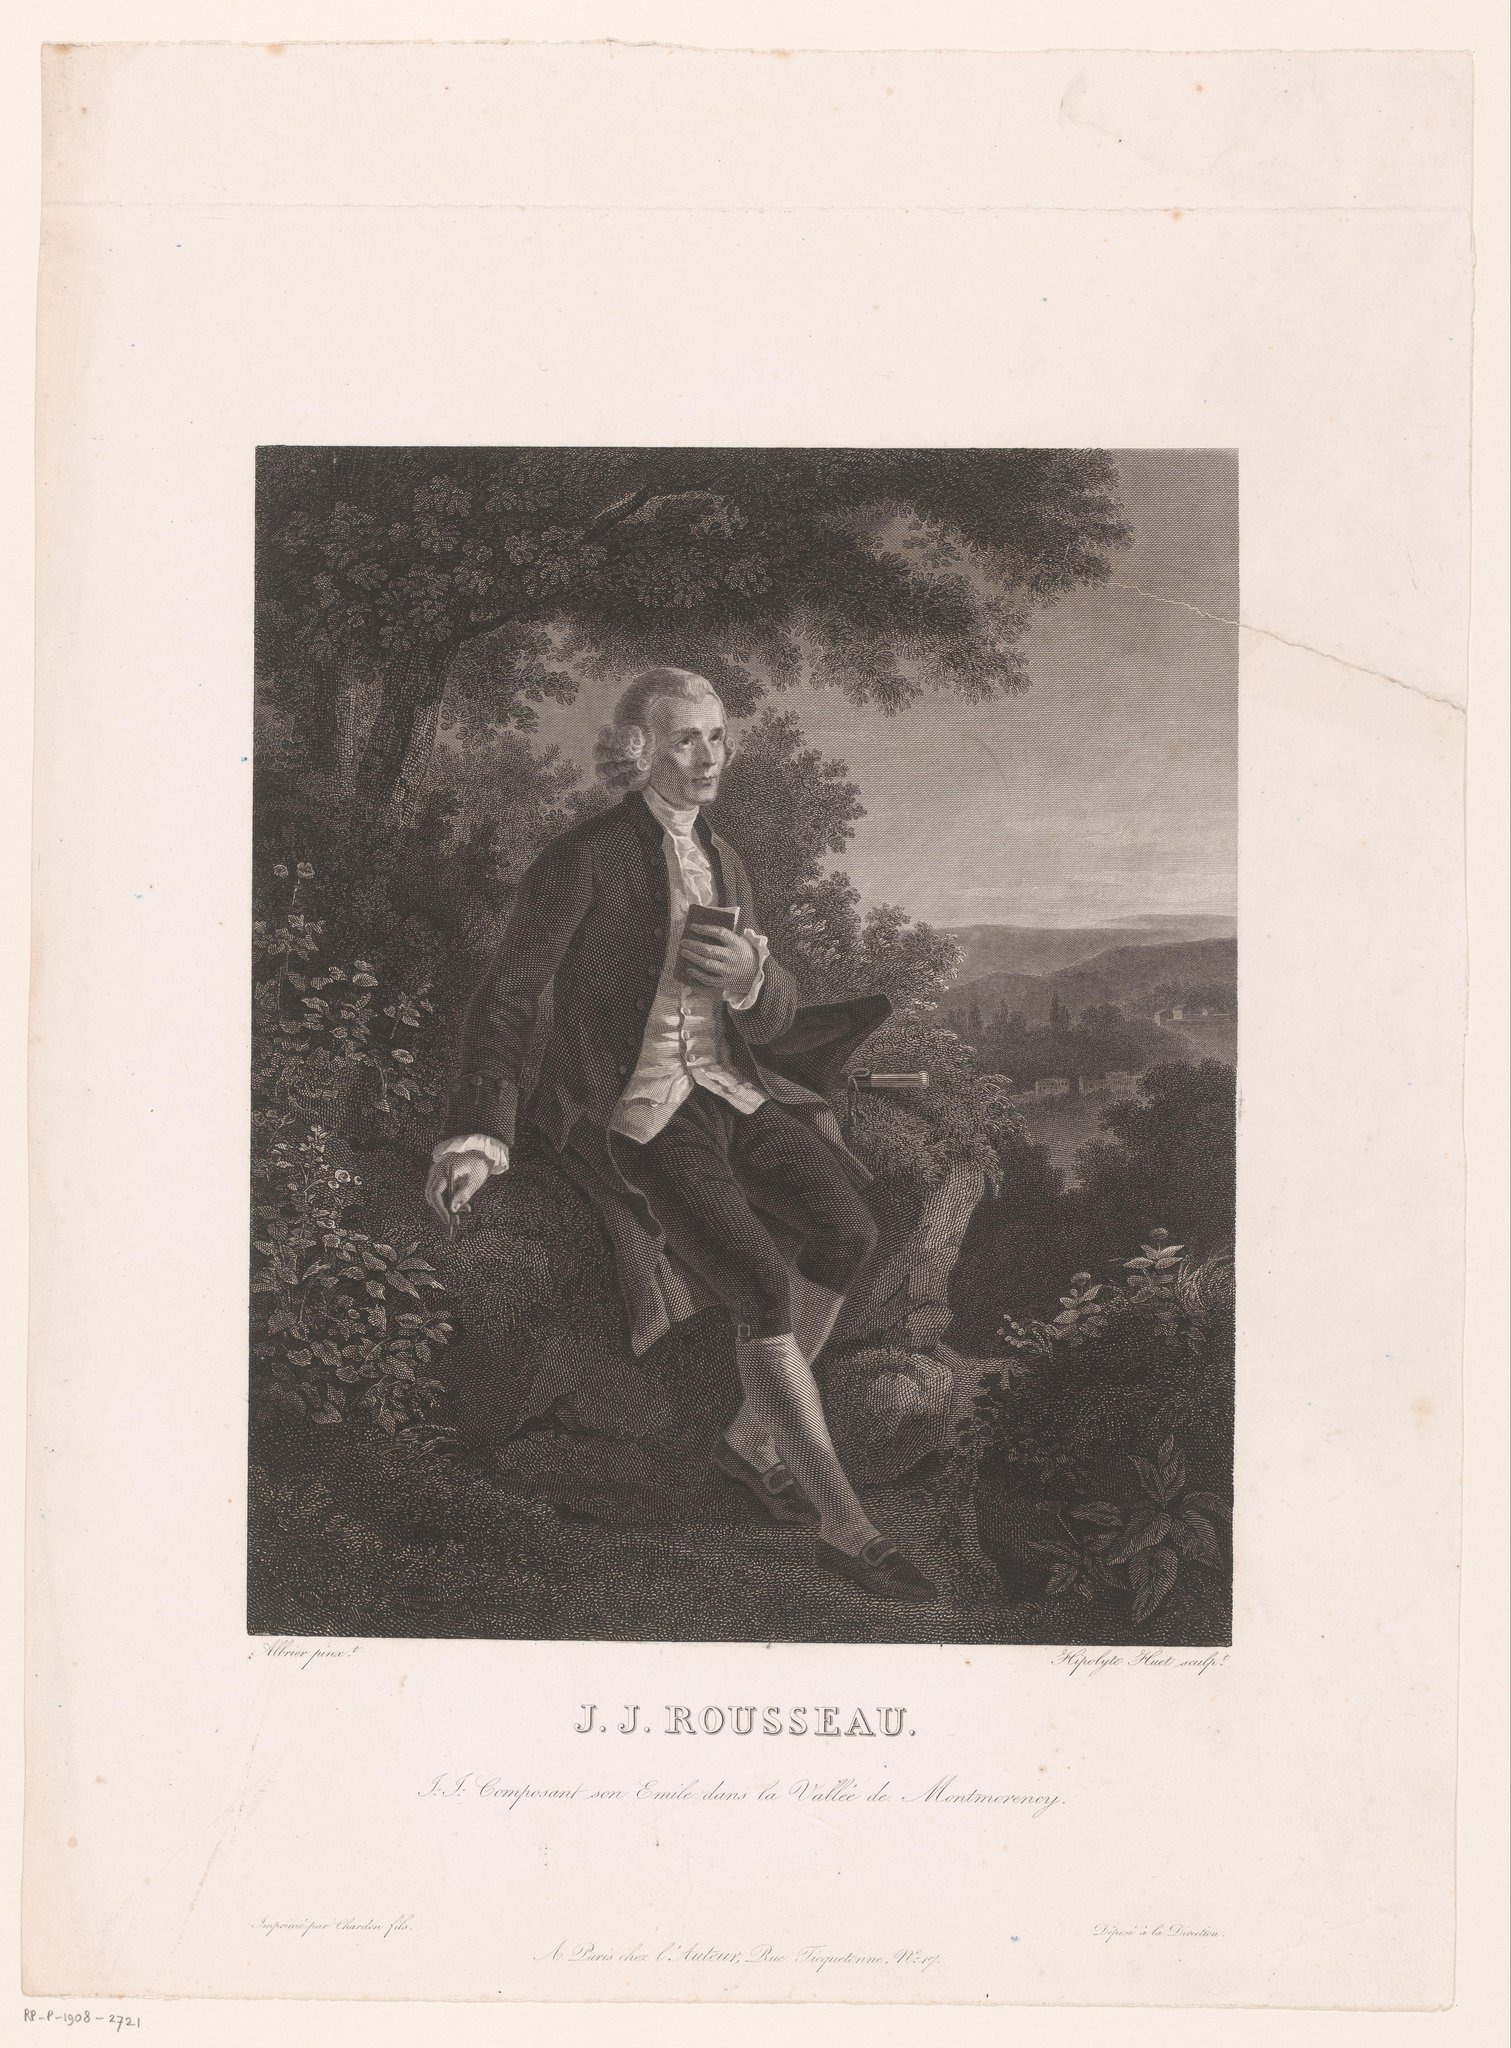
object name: print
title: Portret van Jean-Jacques Rousseau, gezeten op een rots in een landschap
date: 1824-1835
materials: paper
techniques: engraving, etching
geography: paris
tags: scholar, philosopher, historical persons, portrait of a writer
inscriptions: : ‘Déposé à la Direction.’, collector's mark: Lugt 2228